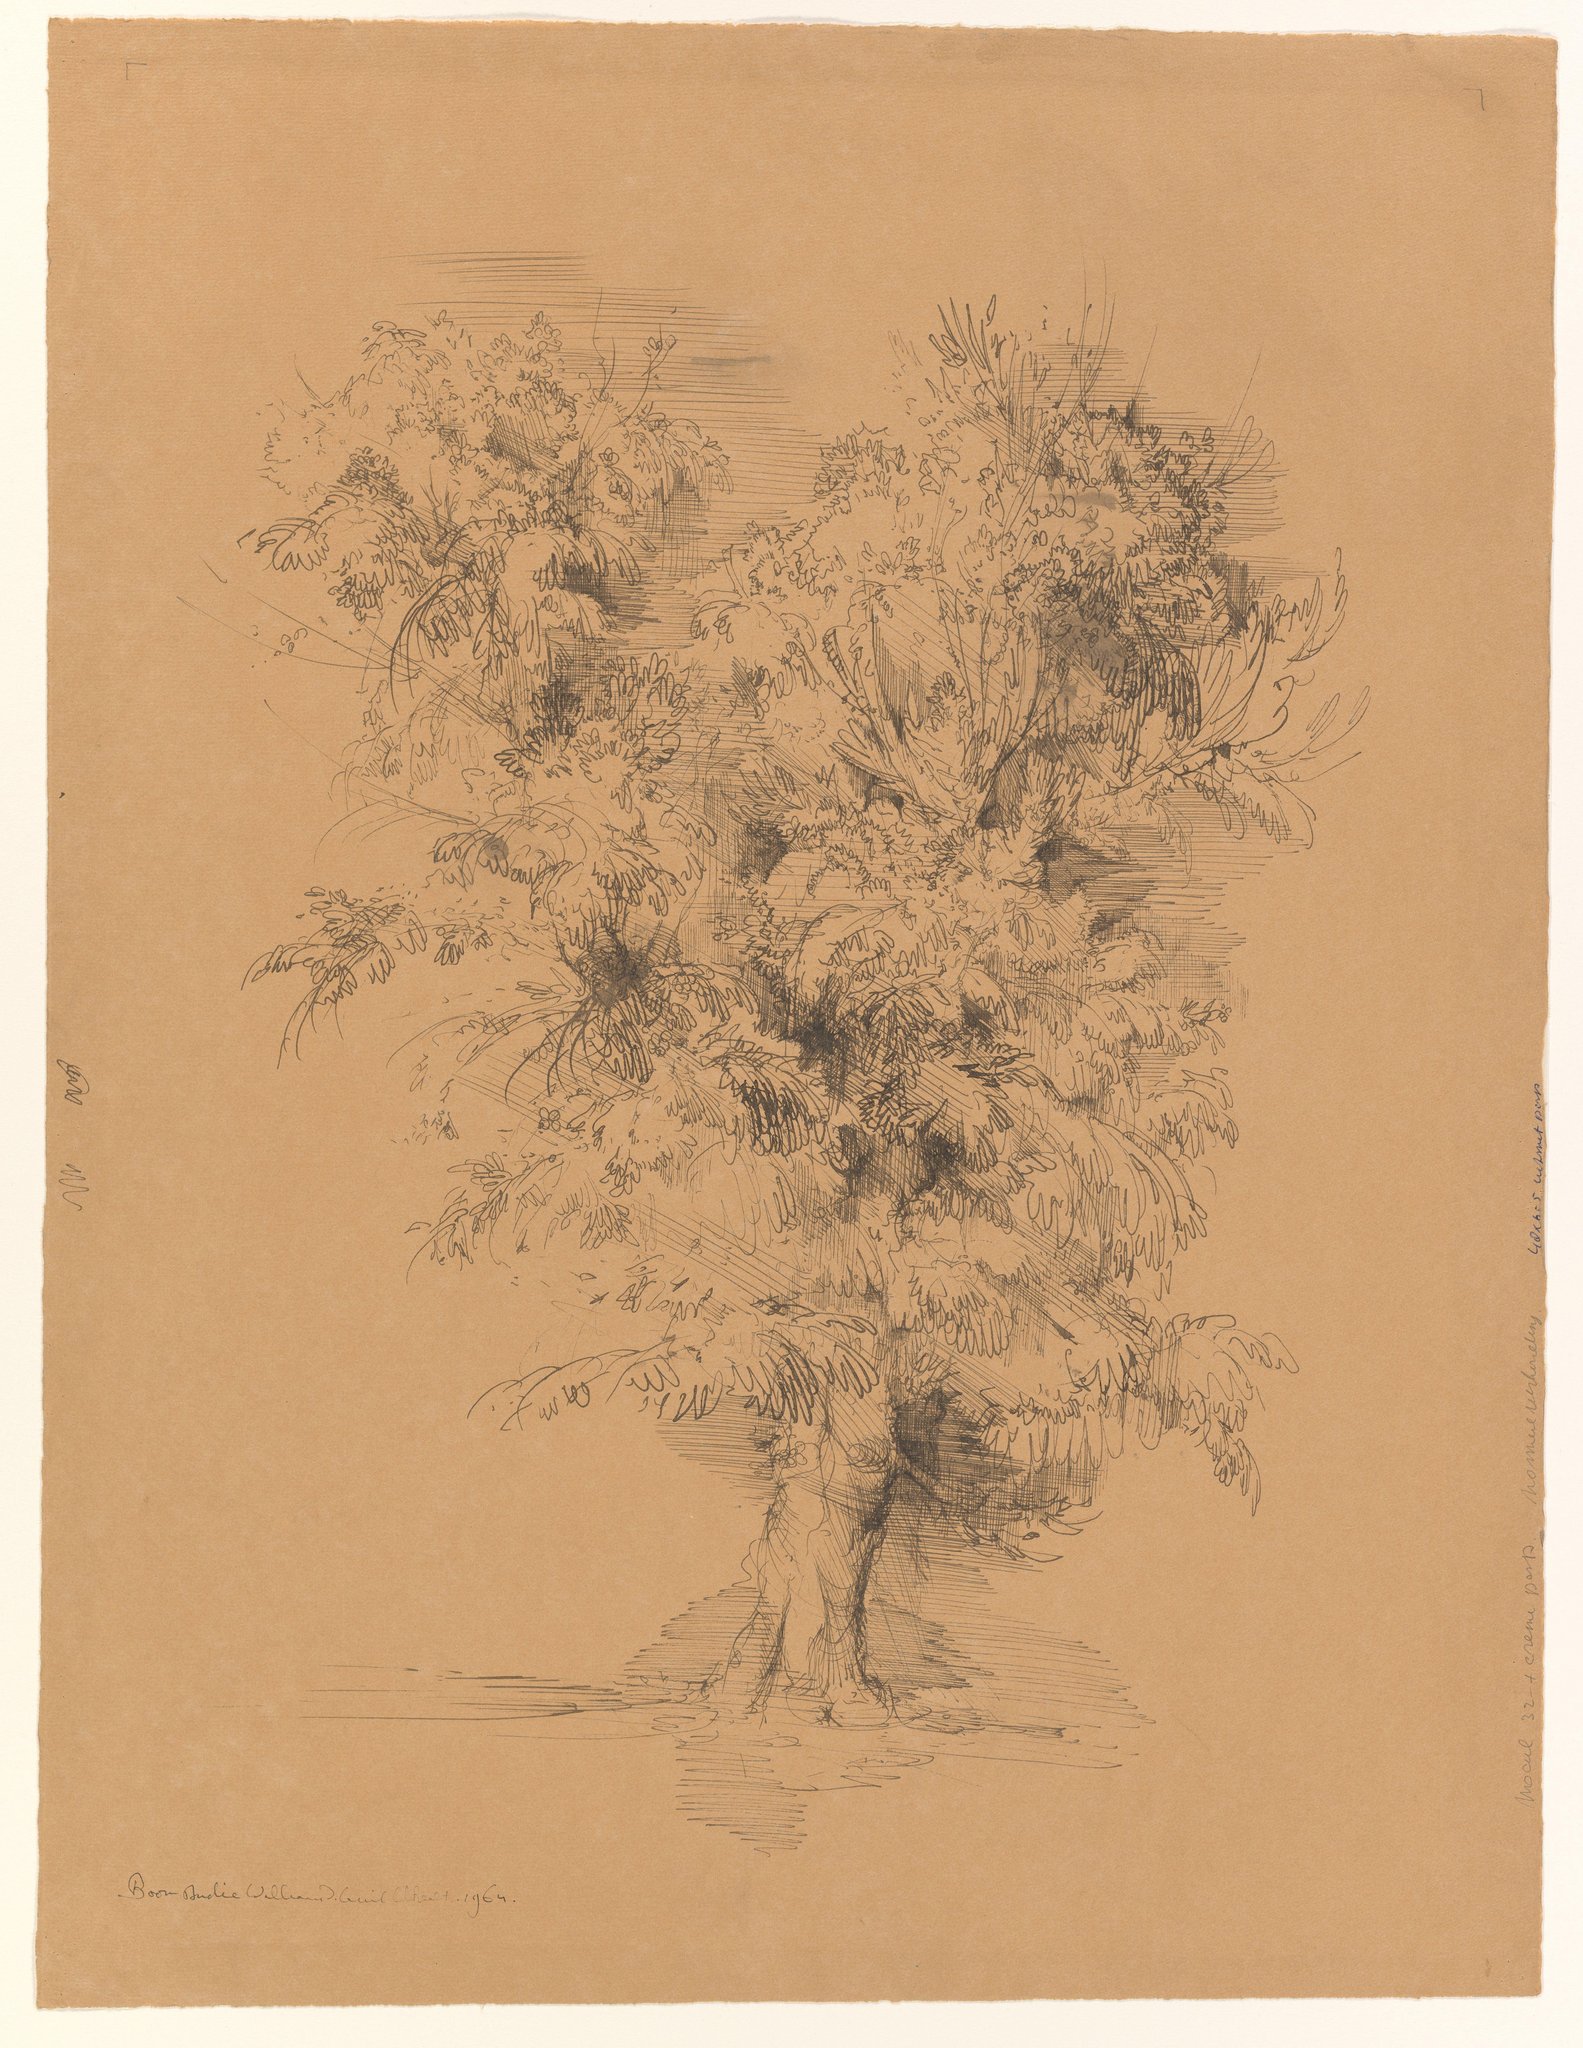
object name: drawing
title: Boomstudie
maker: dirkje kuik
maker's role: print maker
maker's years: 1929-2008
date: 1964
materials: ink, paper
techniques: pen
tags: trees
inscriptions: inscription: ‘48x[...]’, inscription: ‘no[...]’, inscription: ‘Mocul 32-+ creme p[...]’